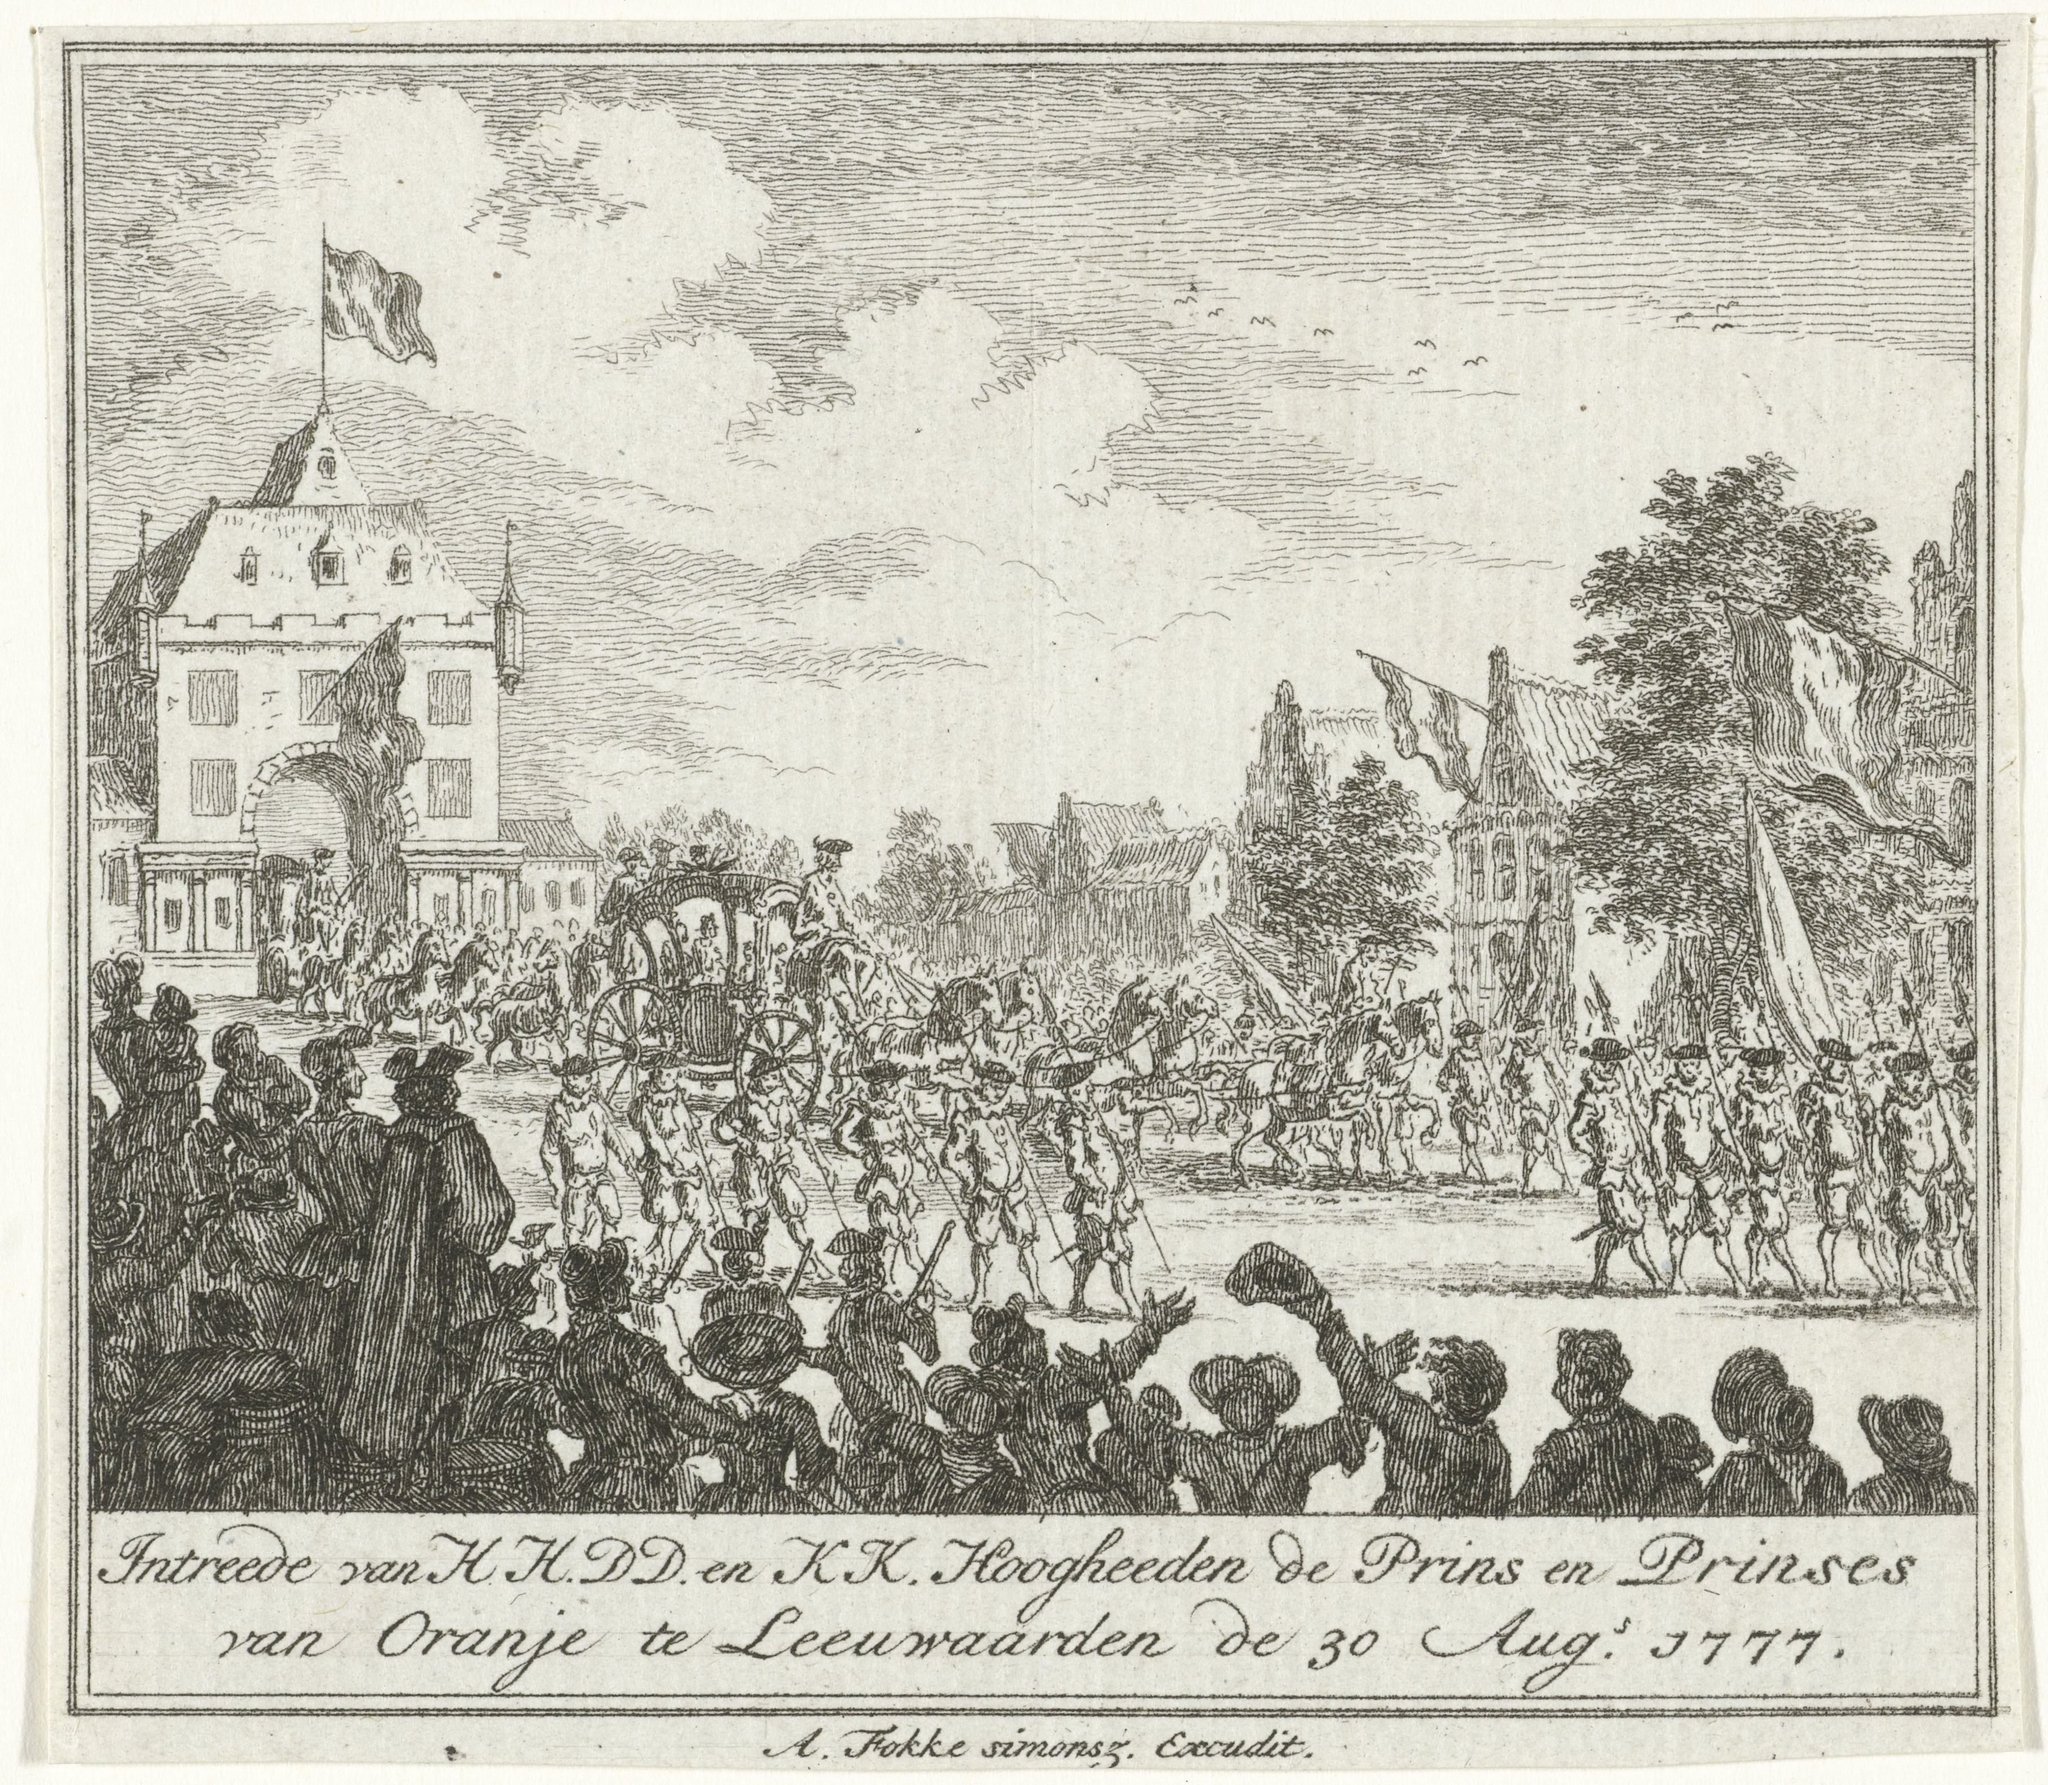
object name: print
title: Intrede van de prins en prinses van Oranje te Leeuwarden, 1777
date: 1783-1784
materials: paper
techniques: engraving, etching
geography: northern netherlands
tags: the hague, william v (prince of orange), berlin, draughtsman, wilhelmina of prussia (princess of orange), triumphal entry and public reception, pageant, 'entrée solennelle', 'joyeuse entrée'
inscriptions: collector's mark: Lugt 2228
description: Gebruikt als illustratie in: Arend Fokke Simonsz. De vaderlandsche historie in themata. Amsterdam: Arend Fokke Simonsz., edities tussen 1783-ca. 1792.